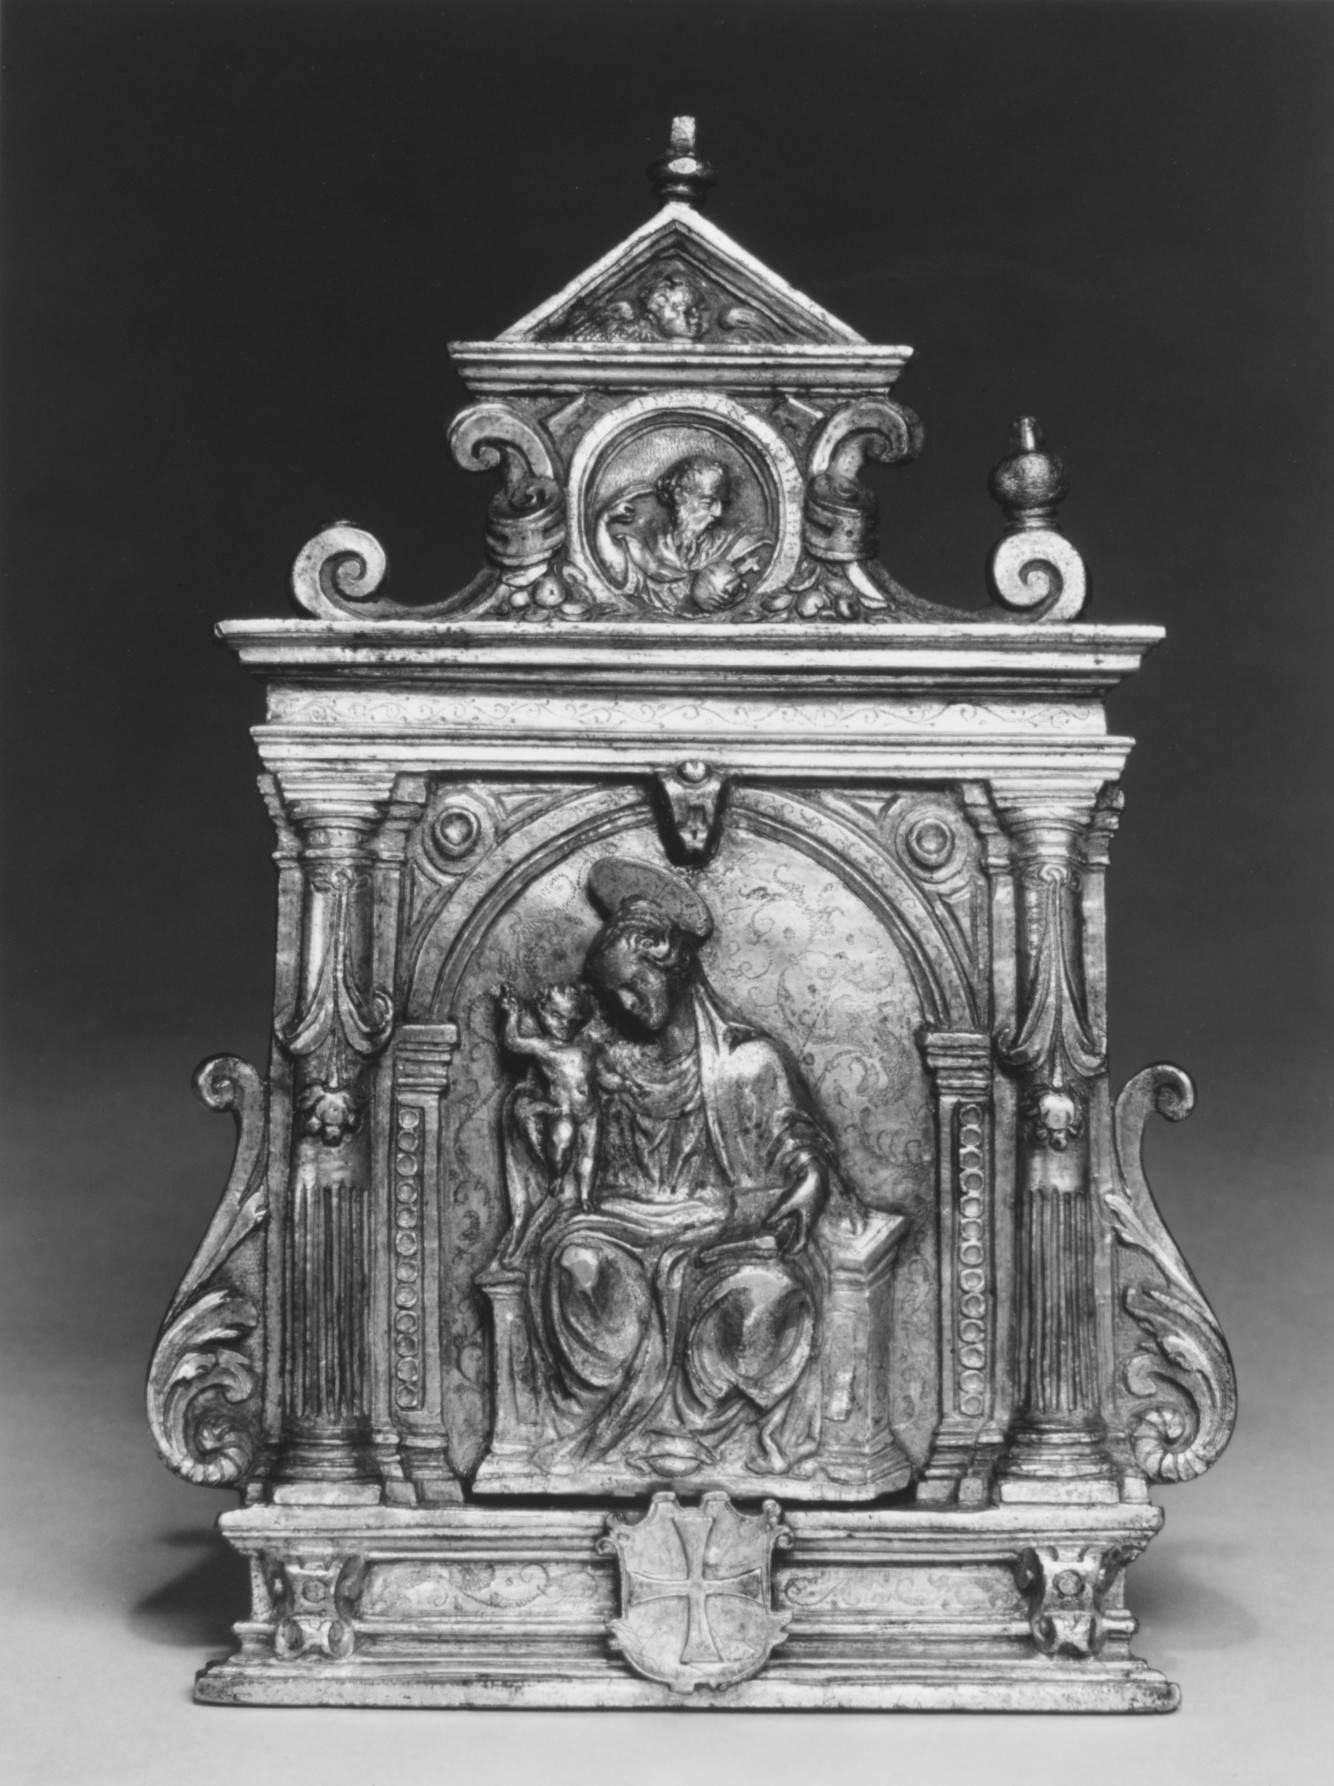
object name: pax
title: Virgin and Child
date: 1534-1566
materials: gilt bronze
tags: madonna and child